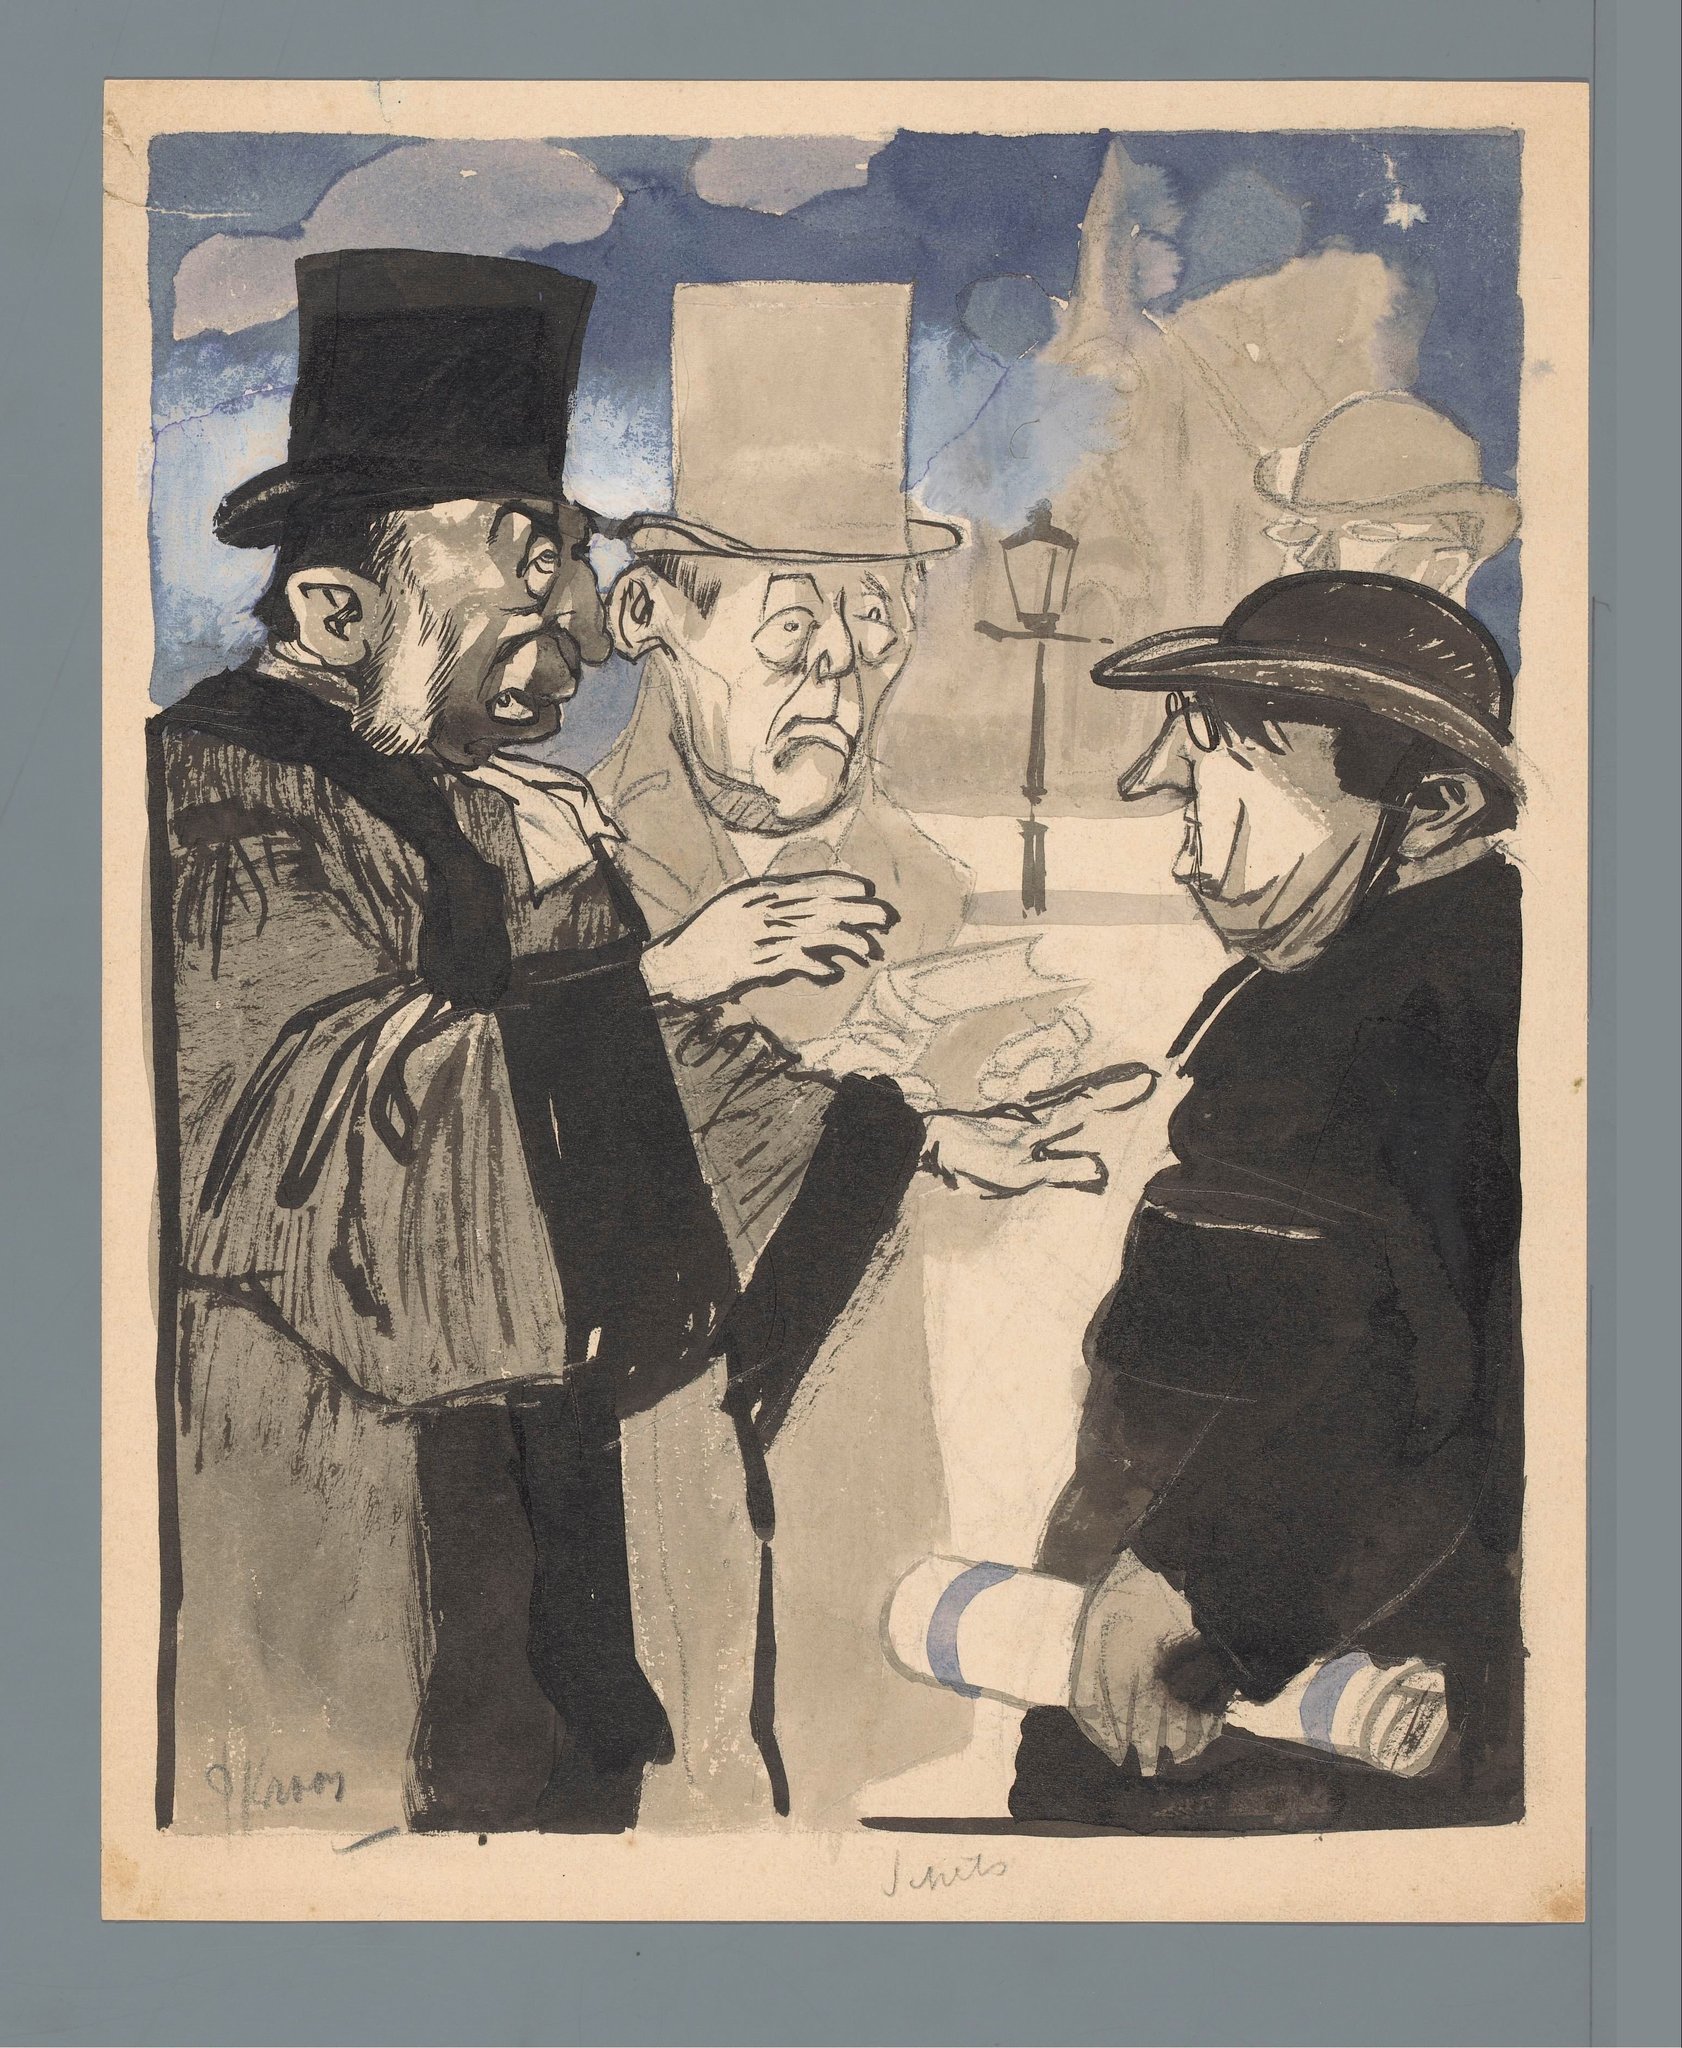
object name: drawing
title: Mannen op straat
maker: patricq kroon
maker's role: draughtsman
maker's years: 1862-1941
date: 1920-1930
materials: ink, paper, pencil, watercolor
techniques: brush, pen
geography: netherlands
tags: priest (roman catholic), political caricatures and satires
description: Twee sombere mannen in hoge hoeden op straat in gesprek met een priester. Schets voor een politieke spotprent.